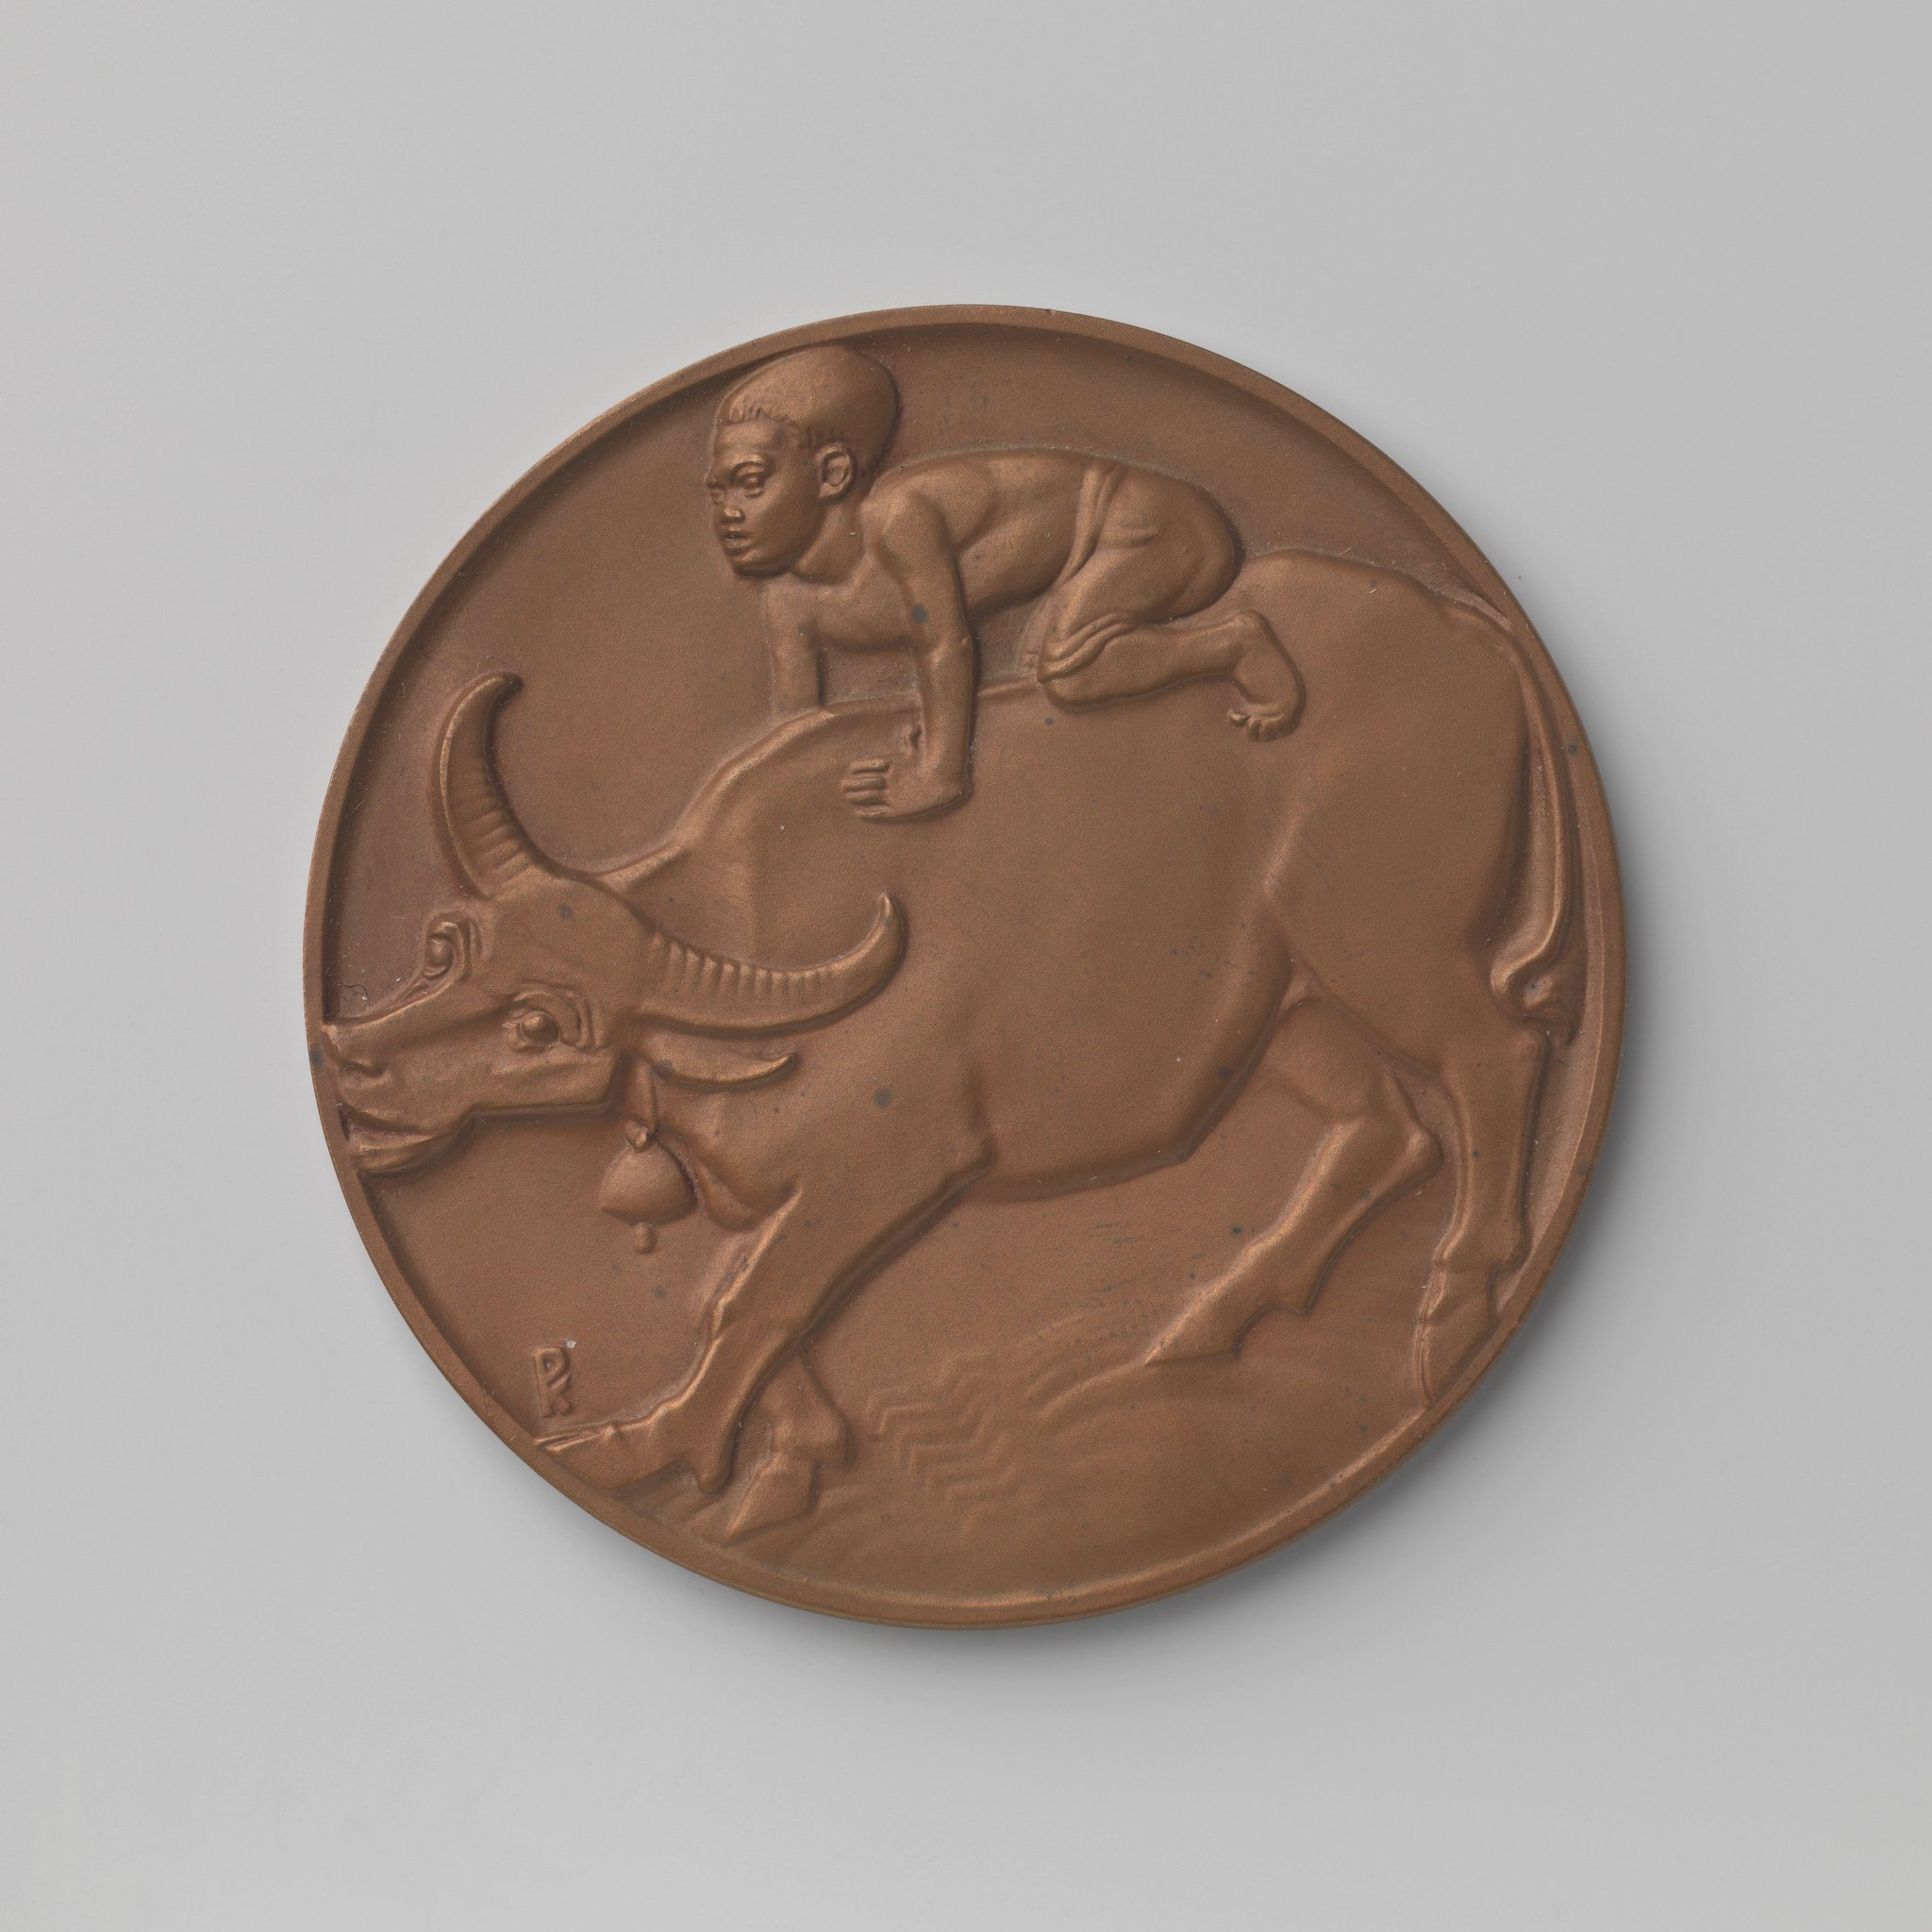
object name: history medal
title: Landbouw in Nederlands-Indië (Vereniging voor Penningkunst 1933, tweede penning)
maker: hendrik albertus van den eijnde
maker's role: sculptor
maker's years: 1869-1939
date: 1933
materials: bronze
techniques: striking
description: Bronzen penning, op de voorzijde een jongen op een karbouw naar links, op de keerzijde drie Indische huisjes met omschrift, met verklaring